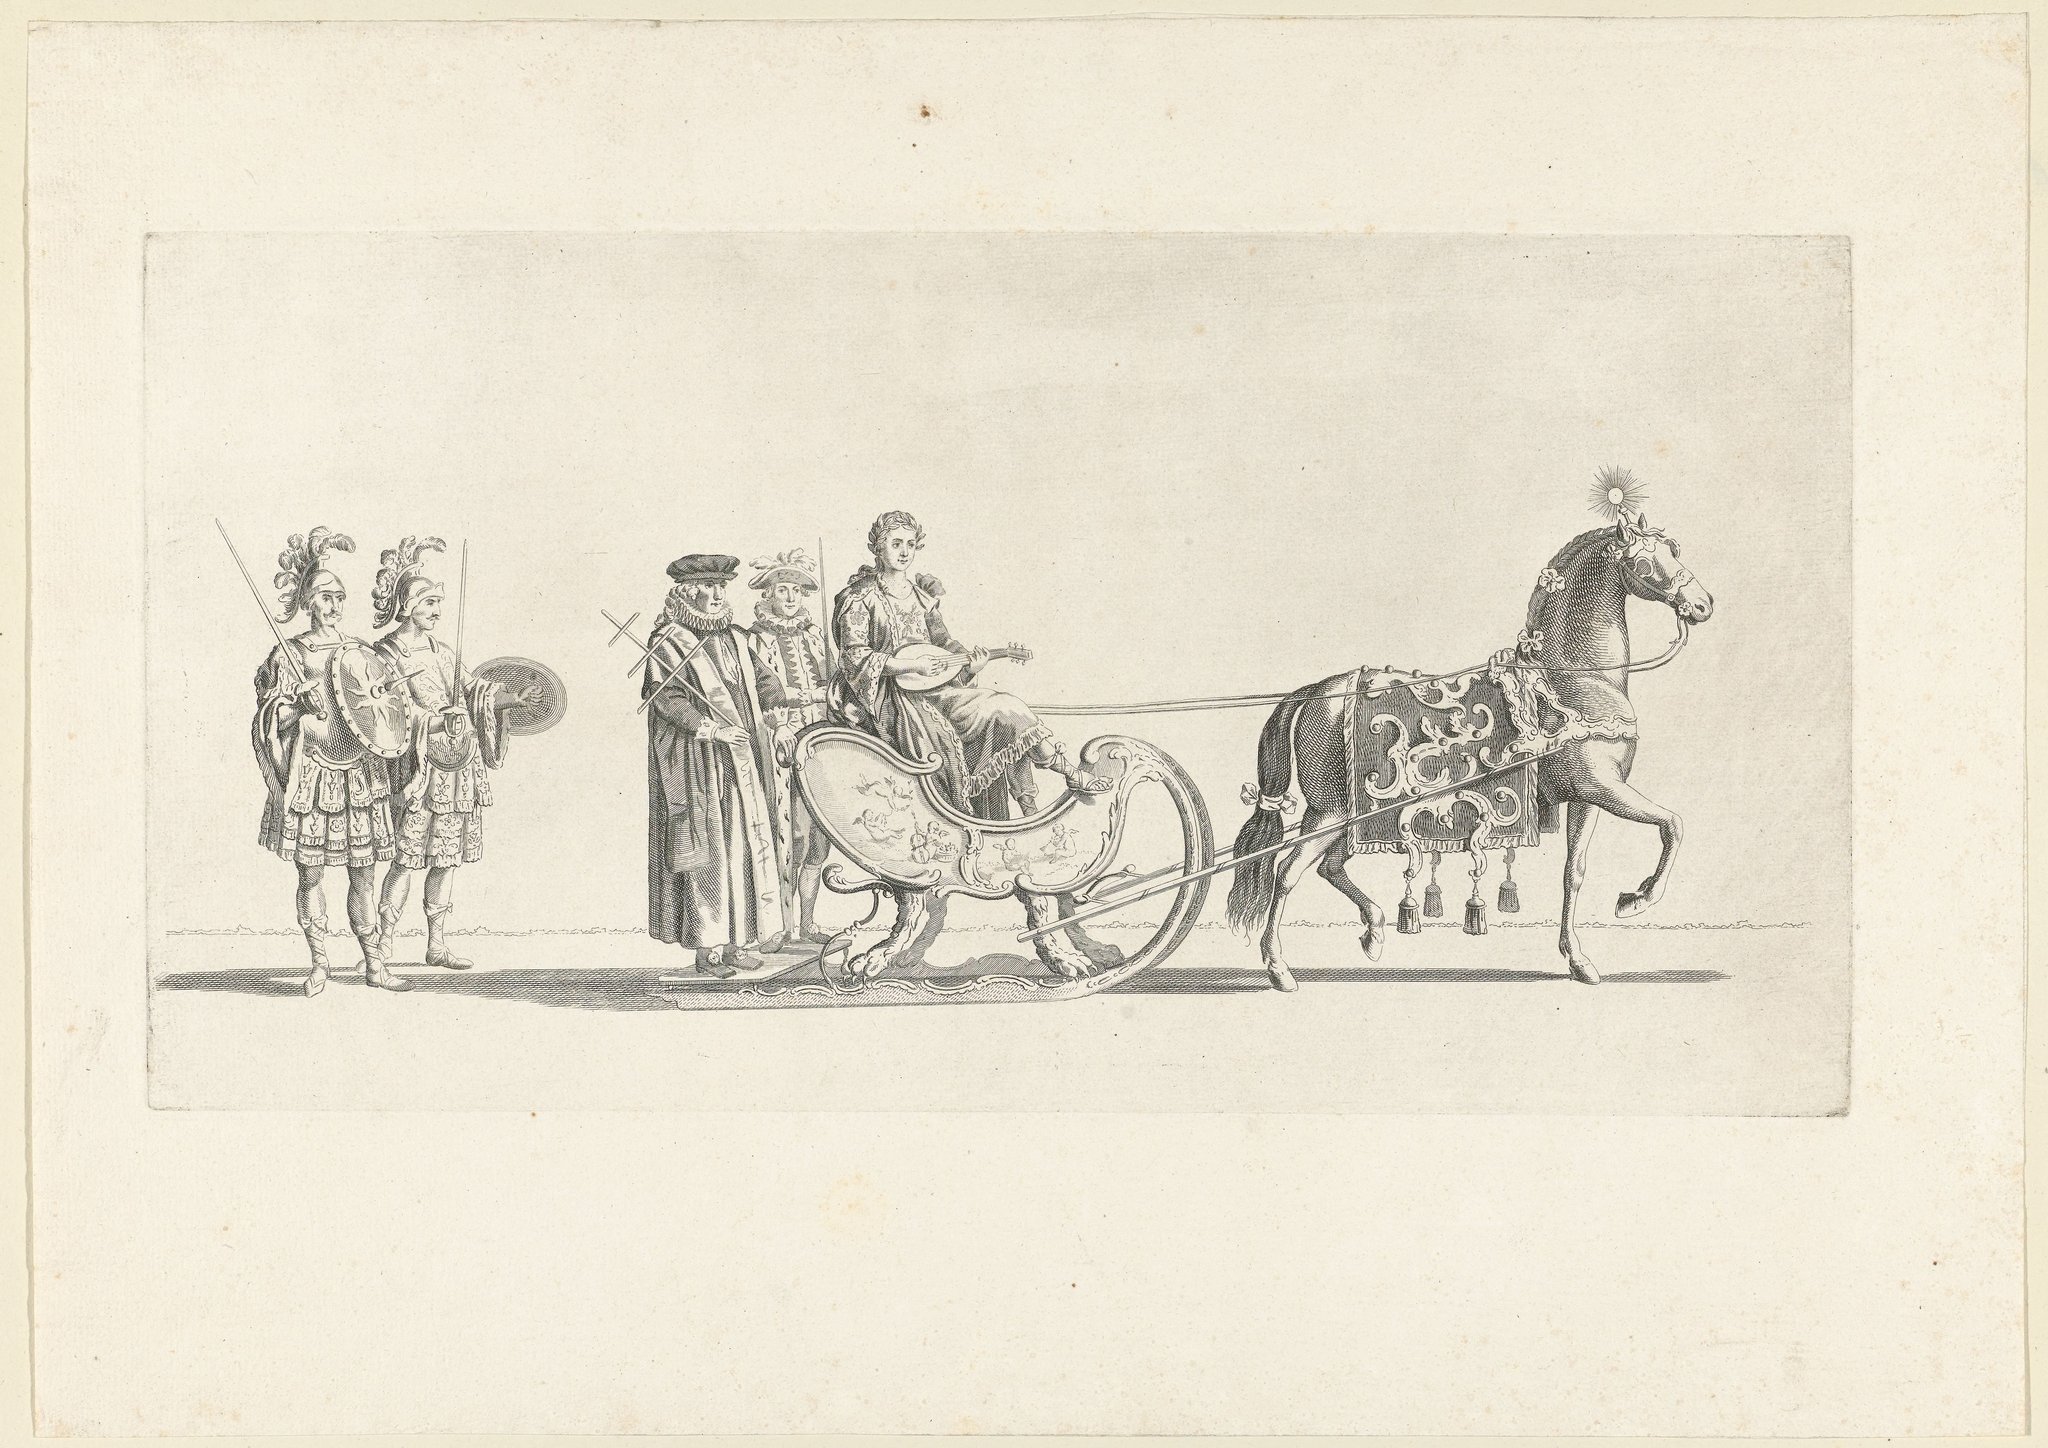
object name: print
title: Elfde slede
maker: nicolaas van der worm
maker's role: draughtsman, print maker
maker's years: 1757-1828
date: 1776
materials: paper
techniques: engraving, etching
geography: northern netherlands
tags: sledge, sleigh (winter sports), commemoration of the founding of a university, leiden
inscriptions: collector's mark: Lugt 240, inscription: ‘onafgemaekte Proefdruk / N vd worm’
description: De elfde slede in de optocht. Een slede met de personificatie van de Muziek, getrokken door een paard, gevolgd door twee Romeinse soldaten. Onderdeel van een reeks van twaalf platen (vóór het nummer en op ander papier) van de sledevaart op 24 januari 1776 georganiseerd door het Leidse genootschap Veniam Pro Laude bij gelegenheid van het Tweede Eeuwfeest van het Leids Ontzet (3 oktober 1574) en de oprichting van de Universiteit van Leiden (8 februari 1575).